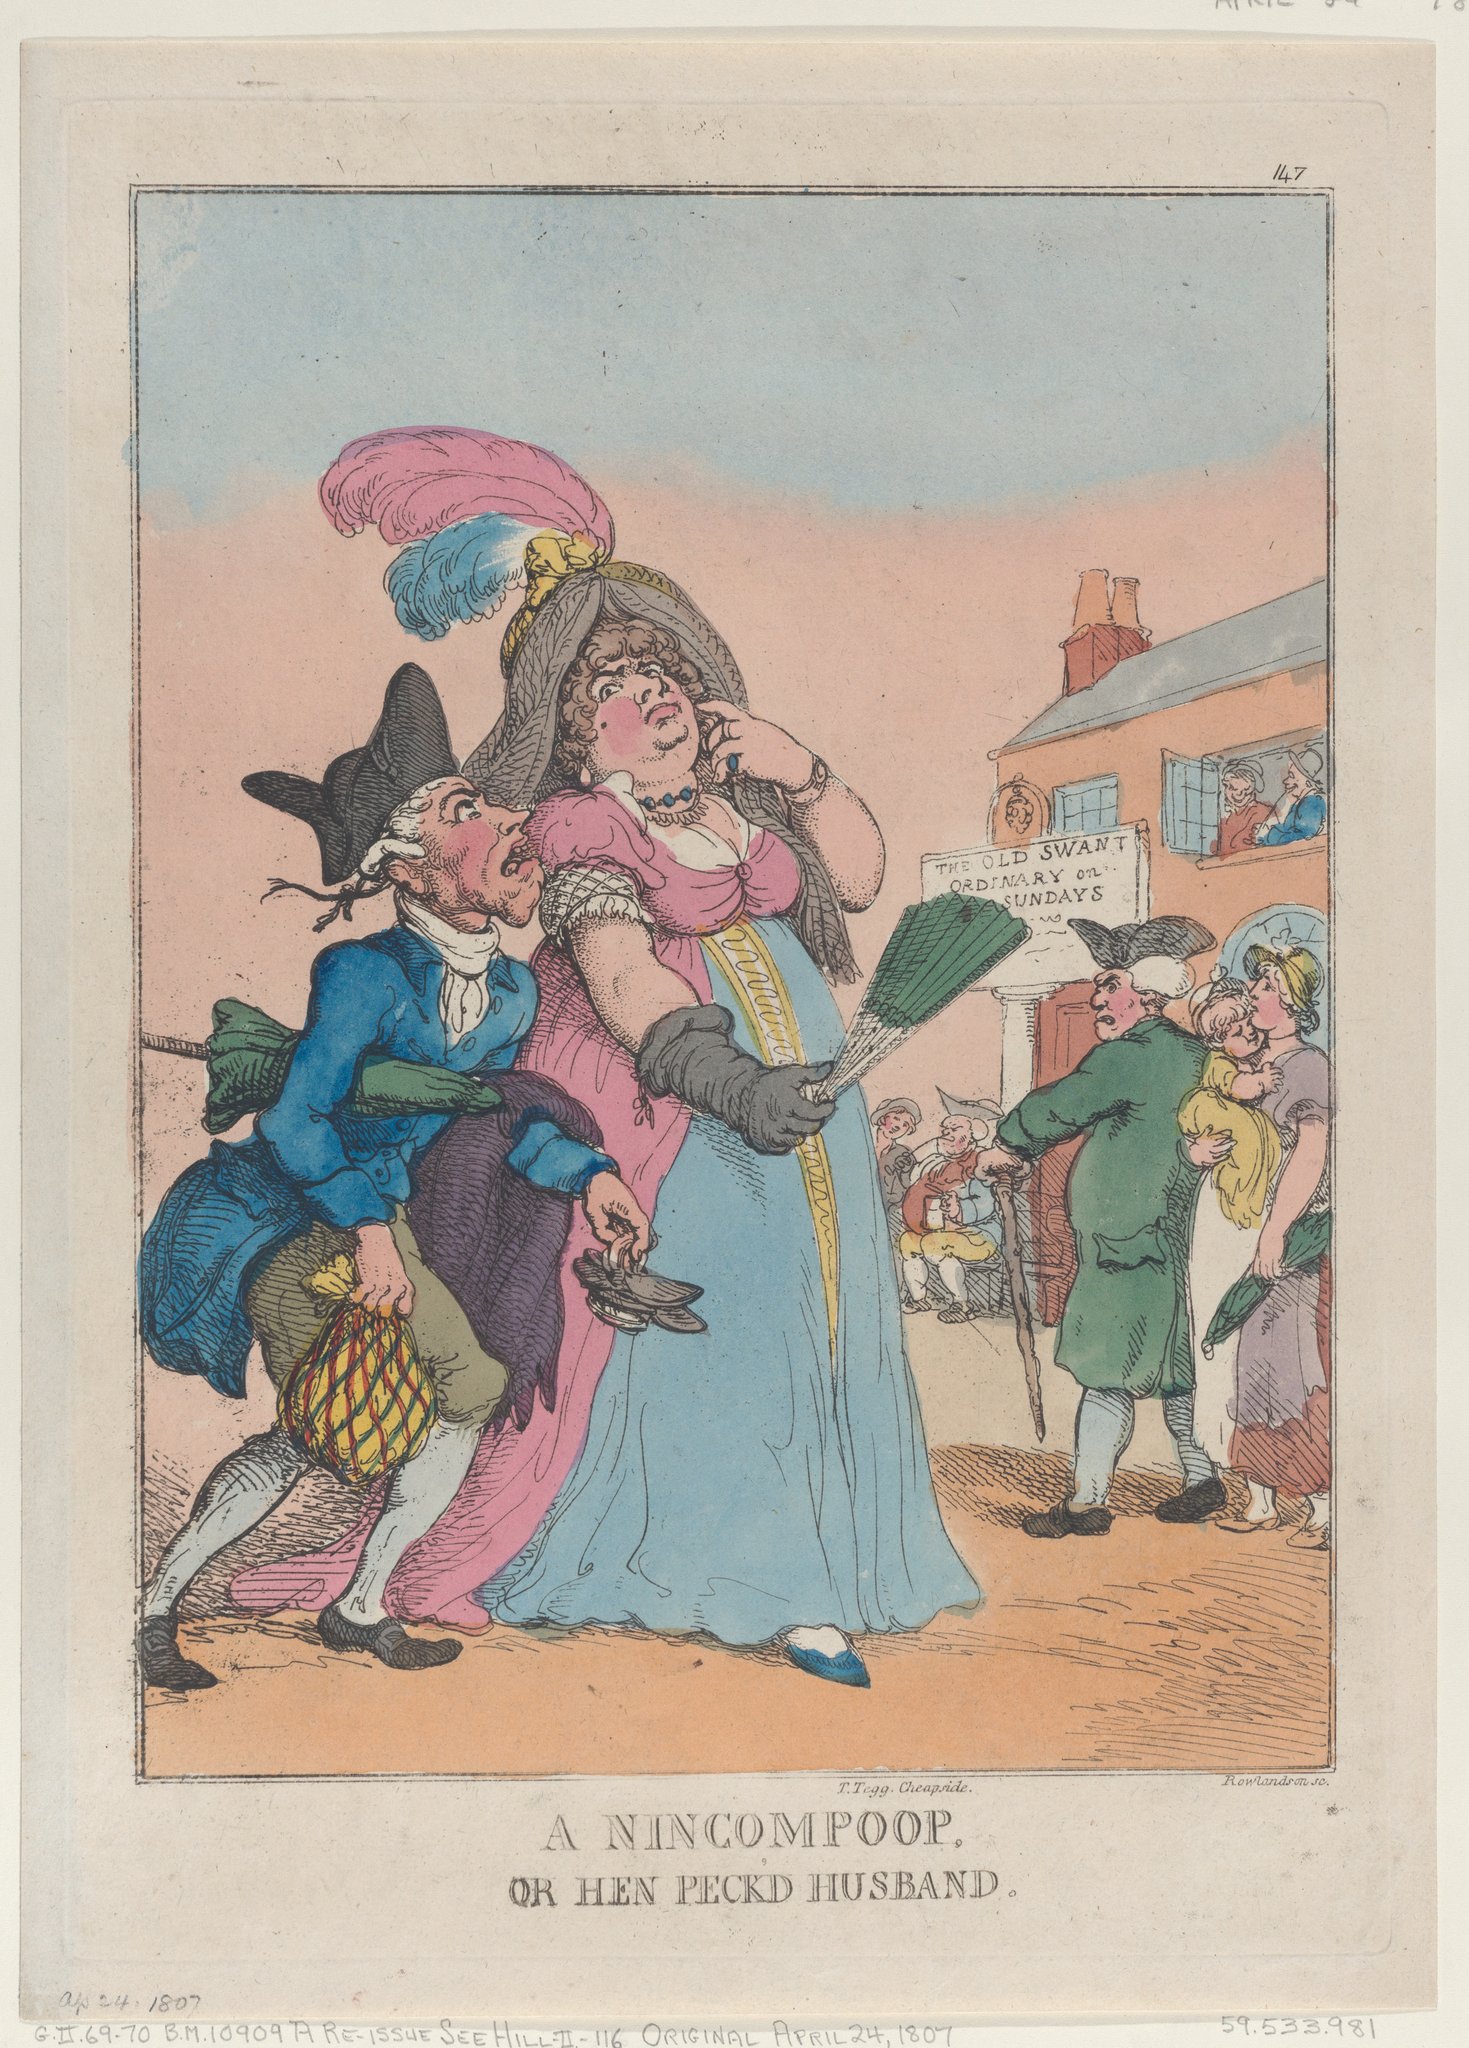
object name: print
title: A Nincompoop, or Hen Peck'd Husband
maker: thomas rowlandson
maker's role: artist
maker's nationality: british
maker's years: 1757-1827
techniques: etching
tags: satire,men,women